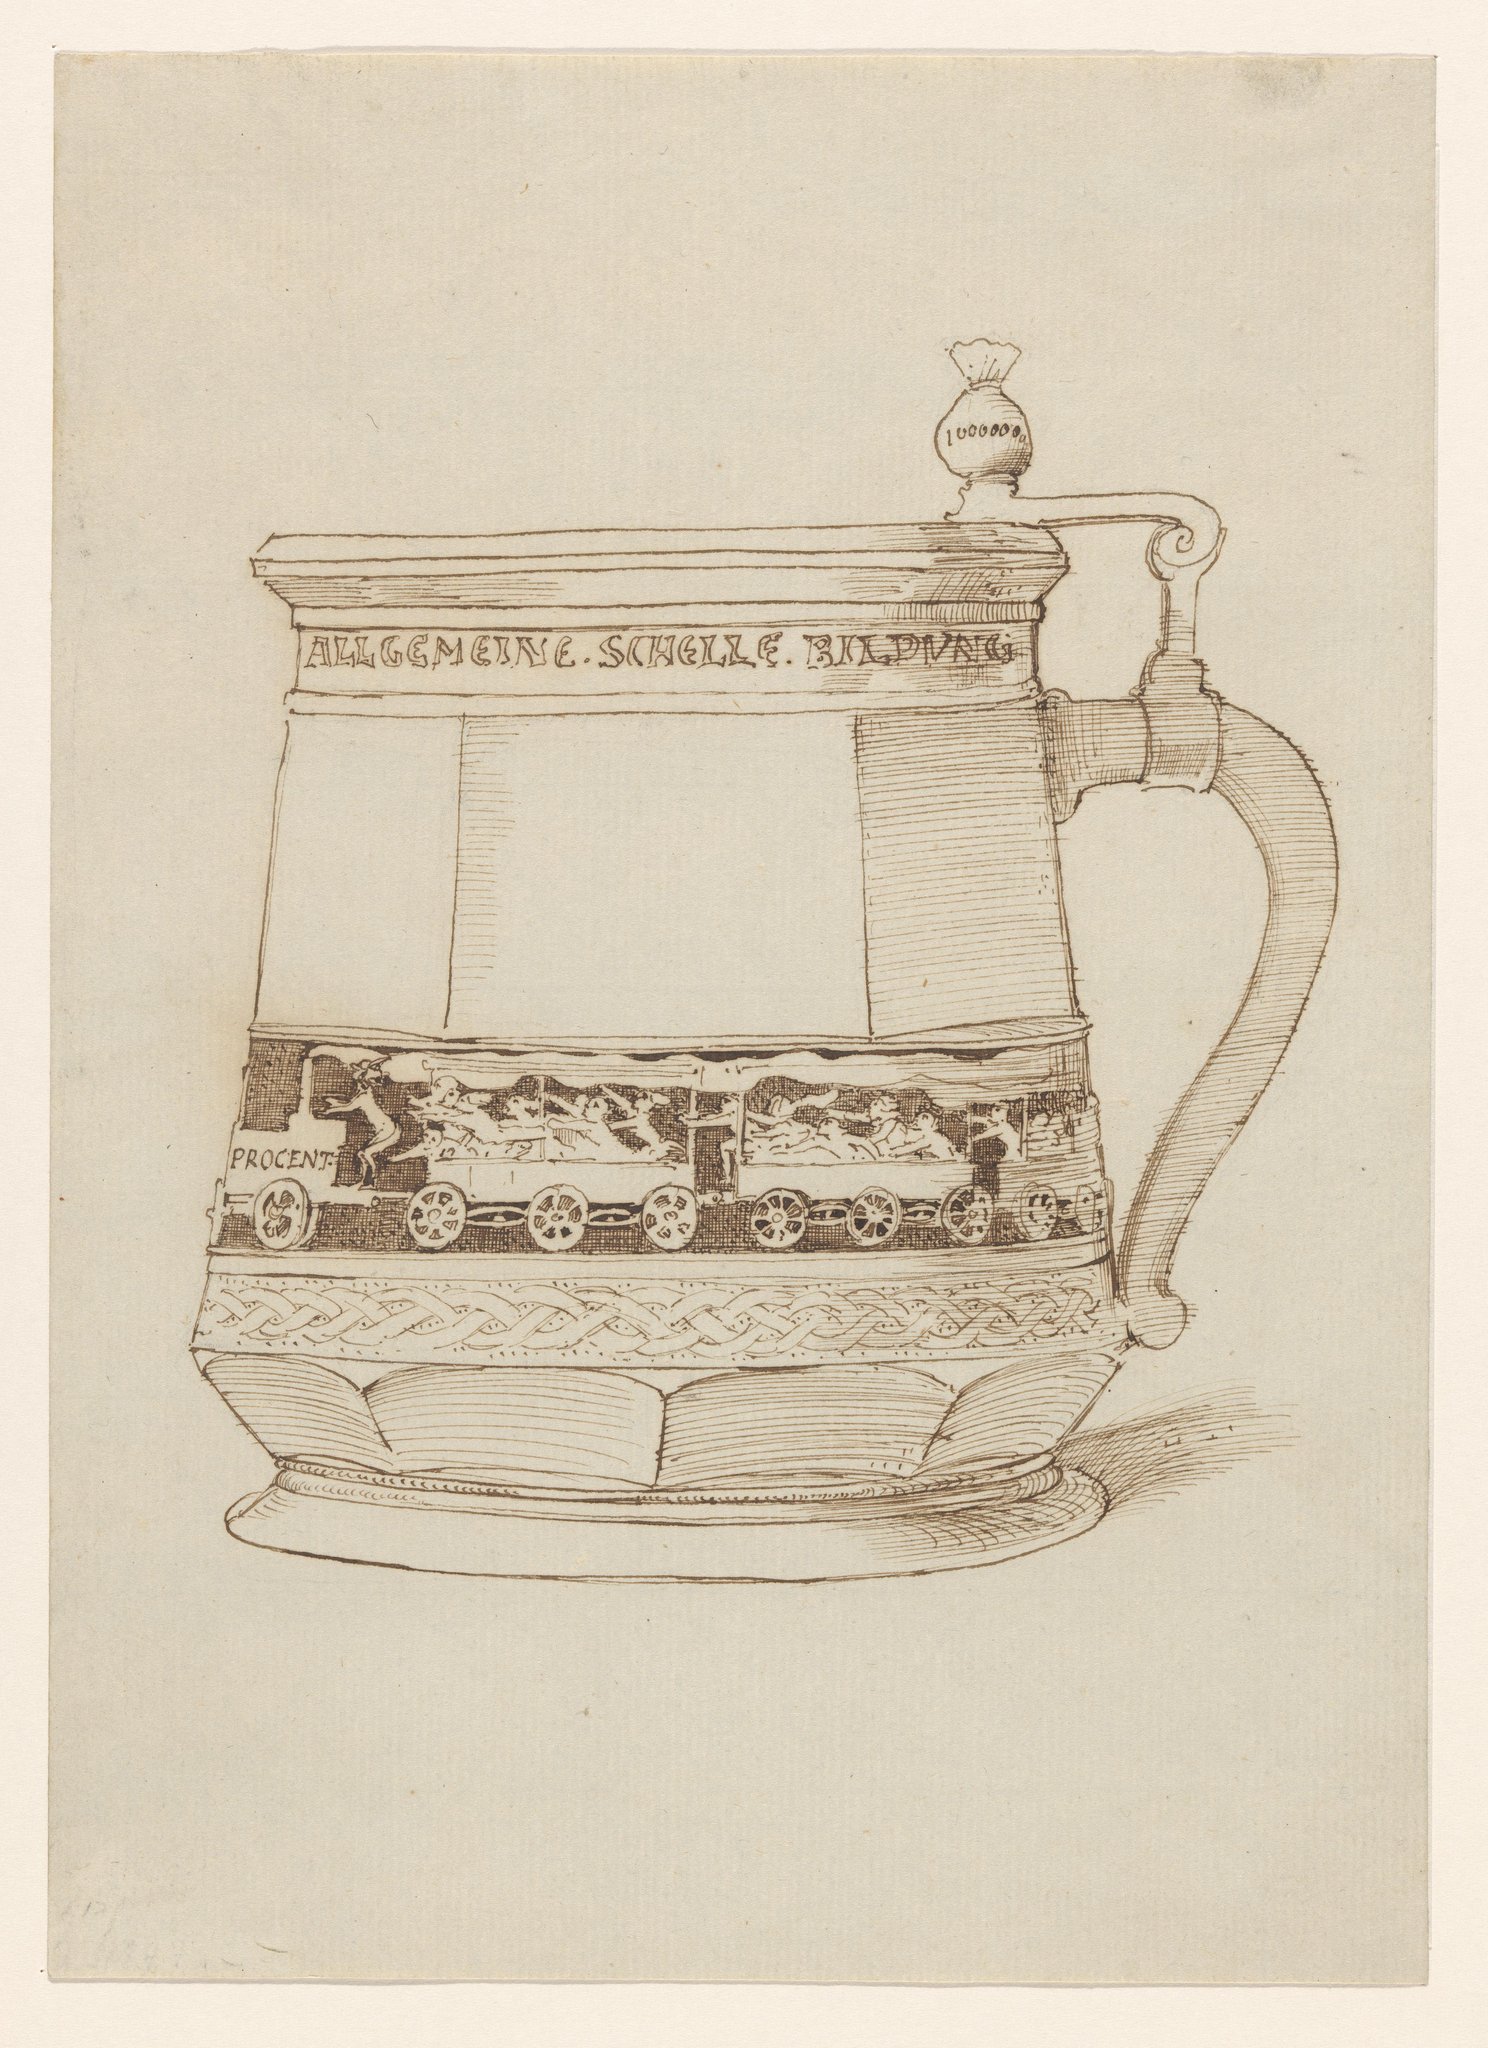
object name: design drawing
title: Ontwerp voor een bierpul met een allegorie op de hebzucht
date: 1835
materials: chalk, ink, paper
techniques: pen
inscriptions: inscription: ‘1000000’, inscription: ‘PROCENT’, watermark, inscription: ‘ALLGEMEINE.SCHELLE.BILDUNG’